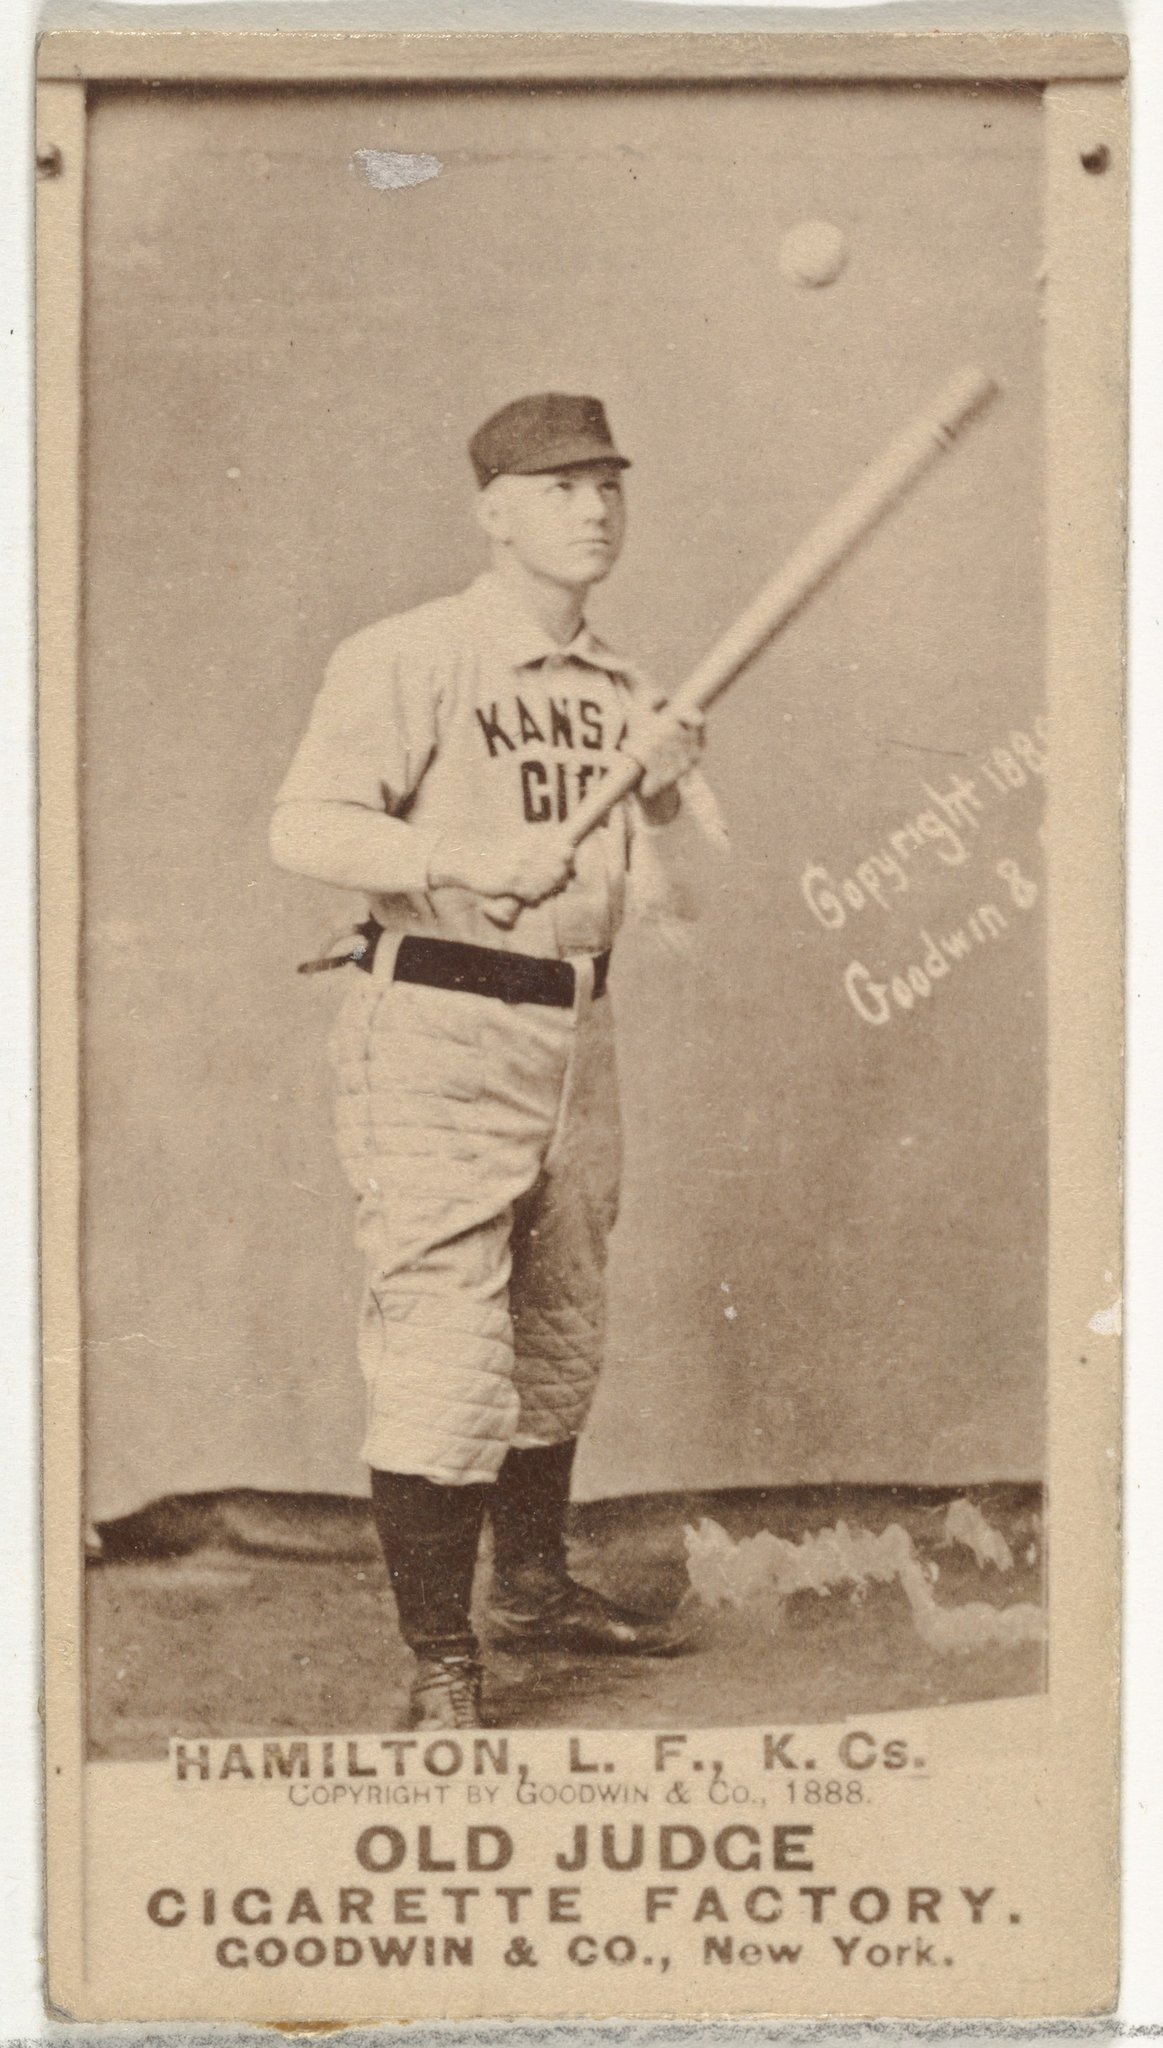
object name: baseball card, photograph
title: William Robert "Sliding Billy" Hamilton, Left Field, Kansas City Cowboys, from the Old Judge series (N172) for Old Judge Cigarettes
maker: goodwin & company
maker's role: publisher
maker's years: 1850-1950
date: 1889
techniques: albumen silver print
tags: men,portraits,baseball,athletes